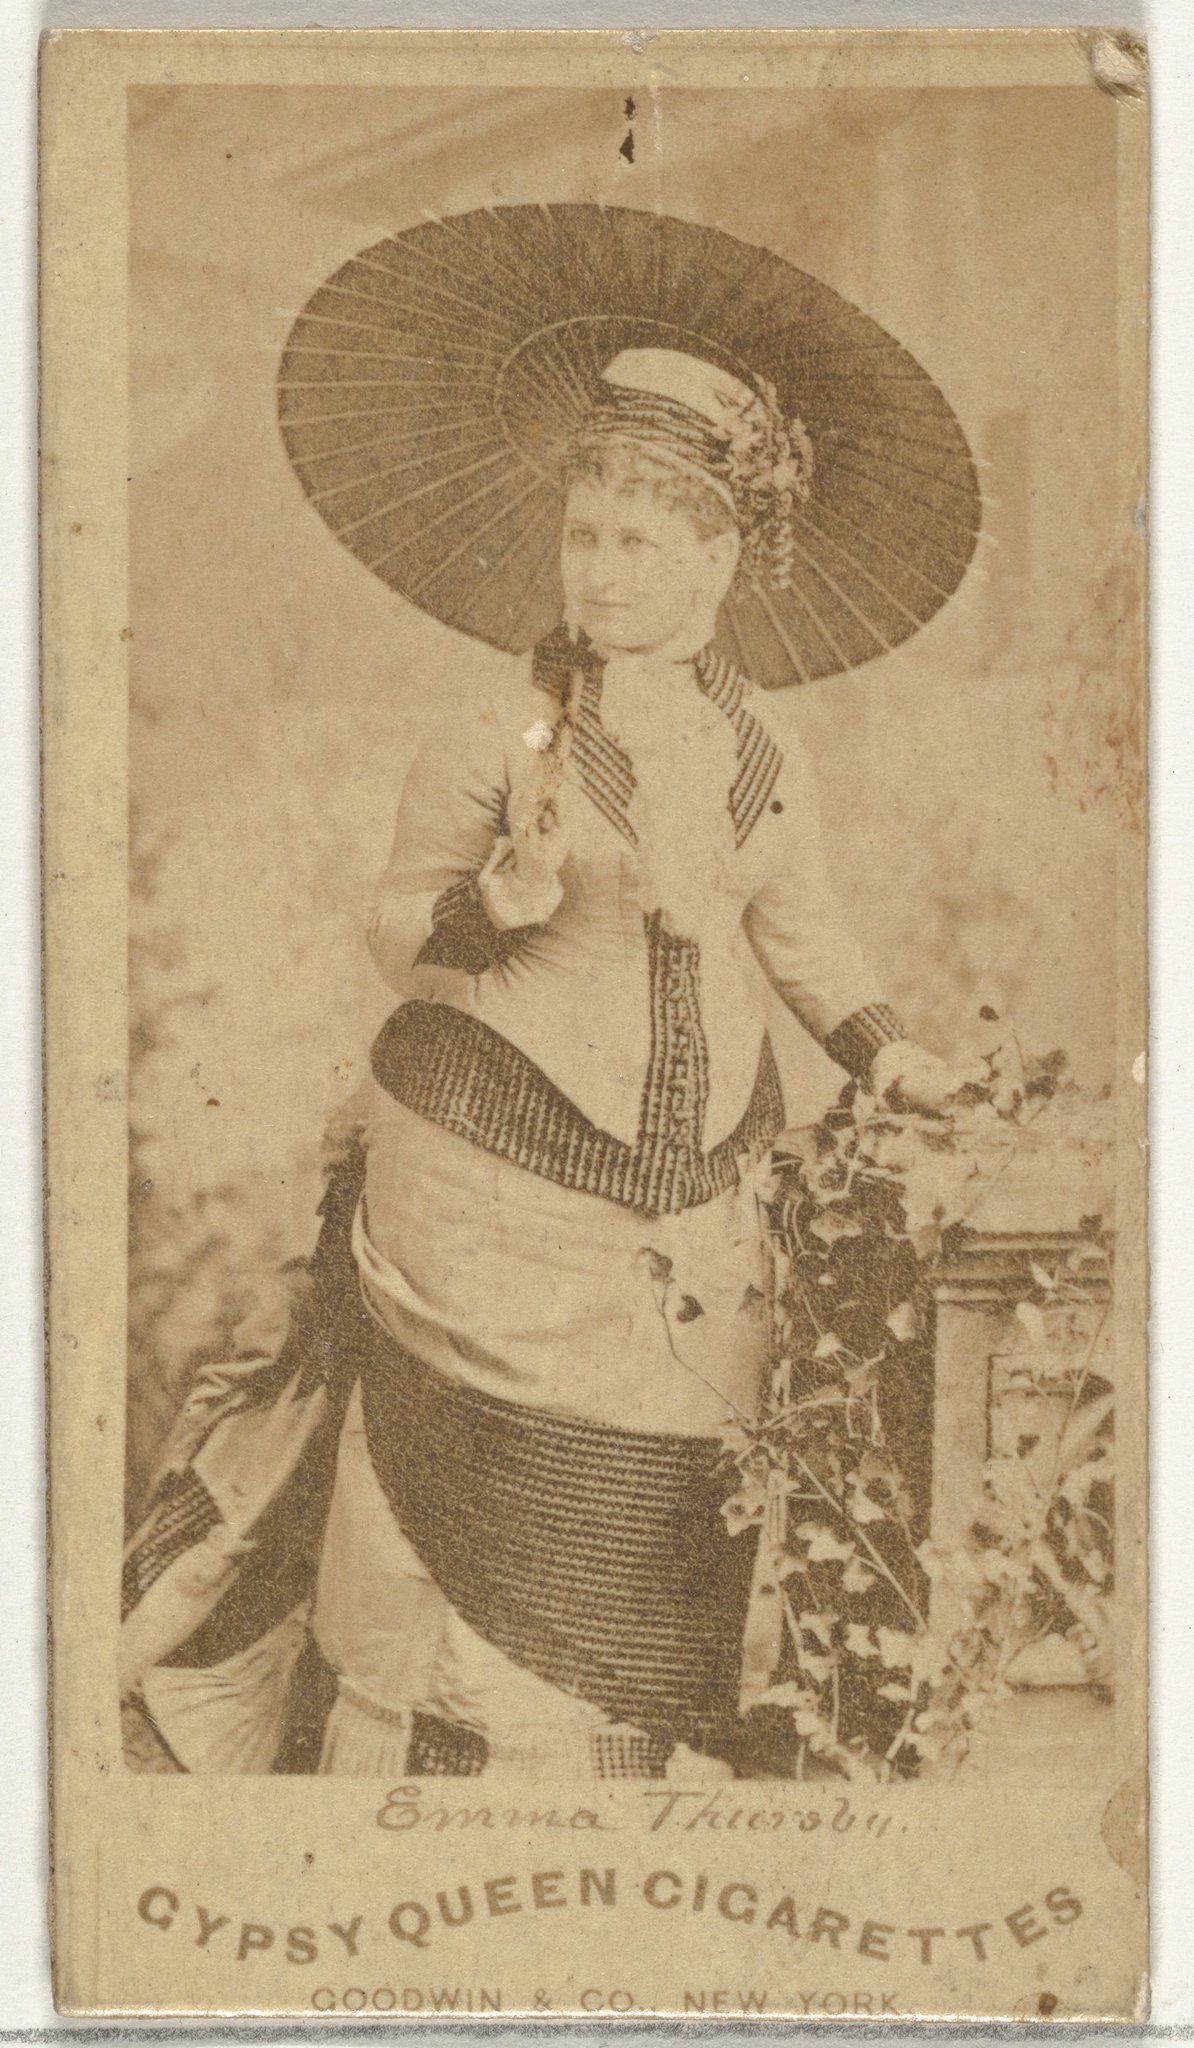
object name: photograph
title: Emma Thiersby, from the Actors and Actresses series (N171) for Gypsy Queen Cigarettes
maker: goodwin & company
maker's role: publisher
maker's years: 1850-1950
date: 1886-1890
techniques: albumen silver print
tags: portraits,women,actresses